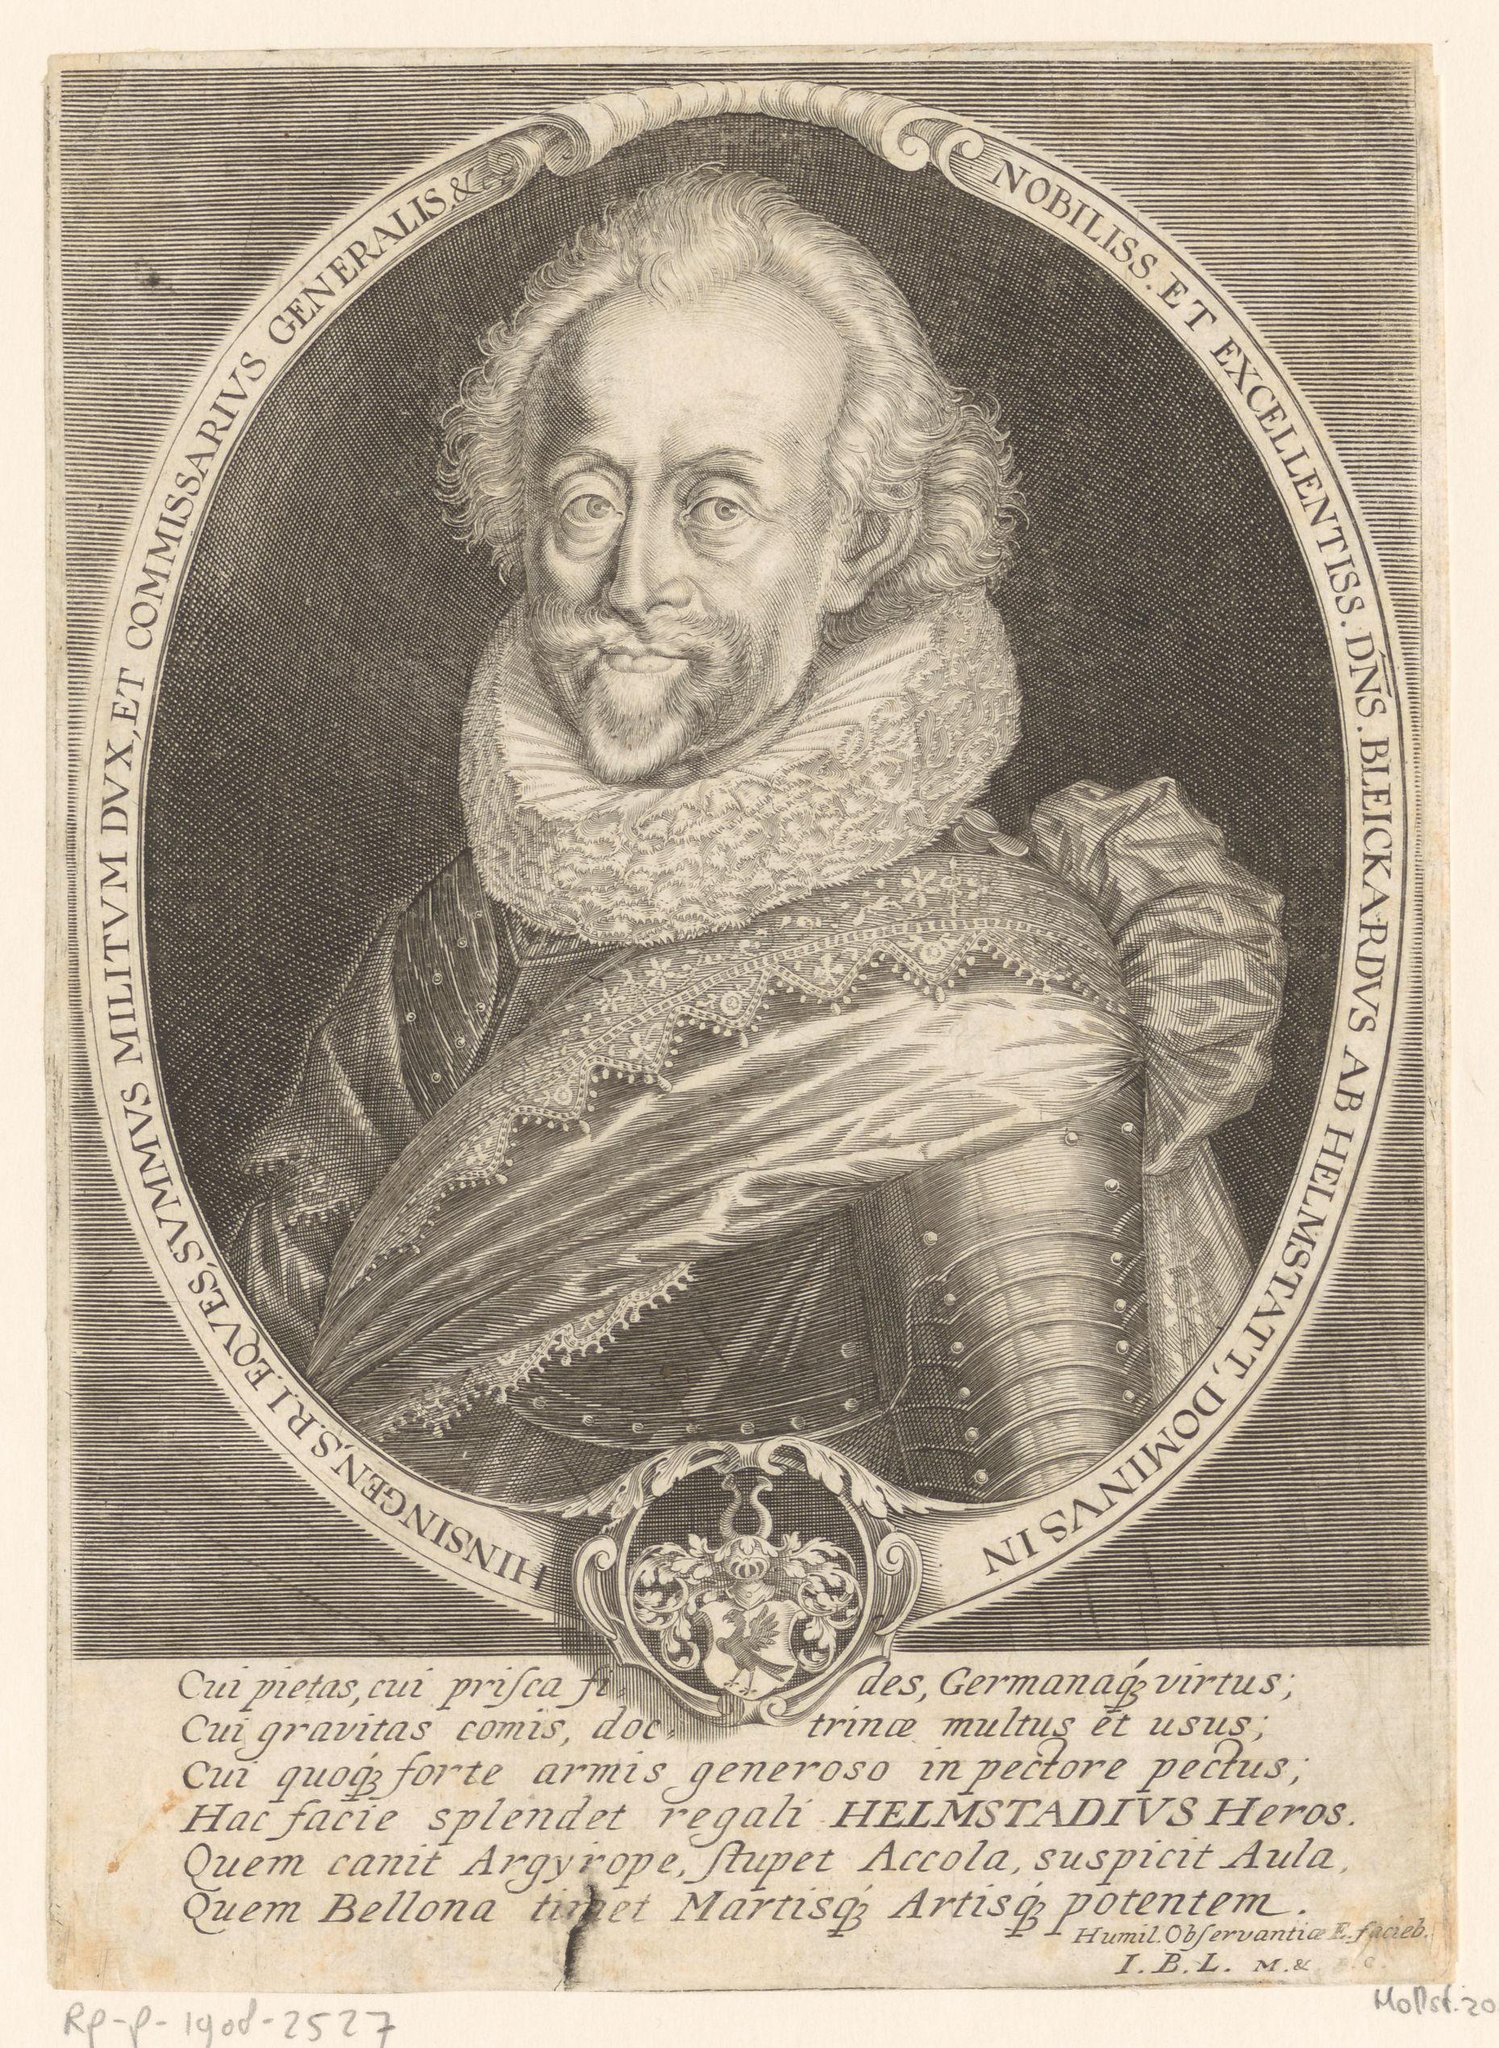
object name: print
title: Portret van Pleickhard von Helmstatt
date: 1591-1662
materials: paper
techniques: engraving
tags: butler, historical persons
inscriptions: collector's mark: Lugt 2228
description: Tekst in het Latijn in de omlijsting en in de ondermarge.